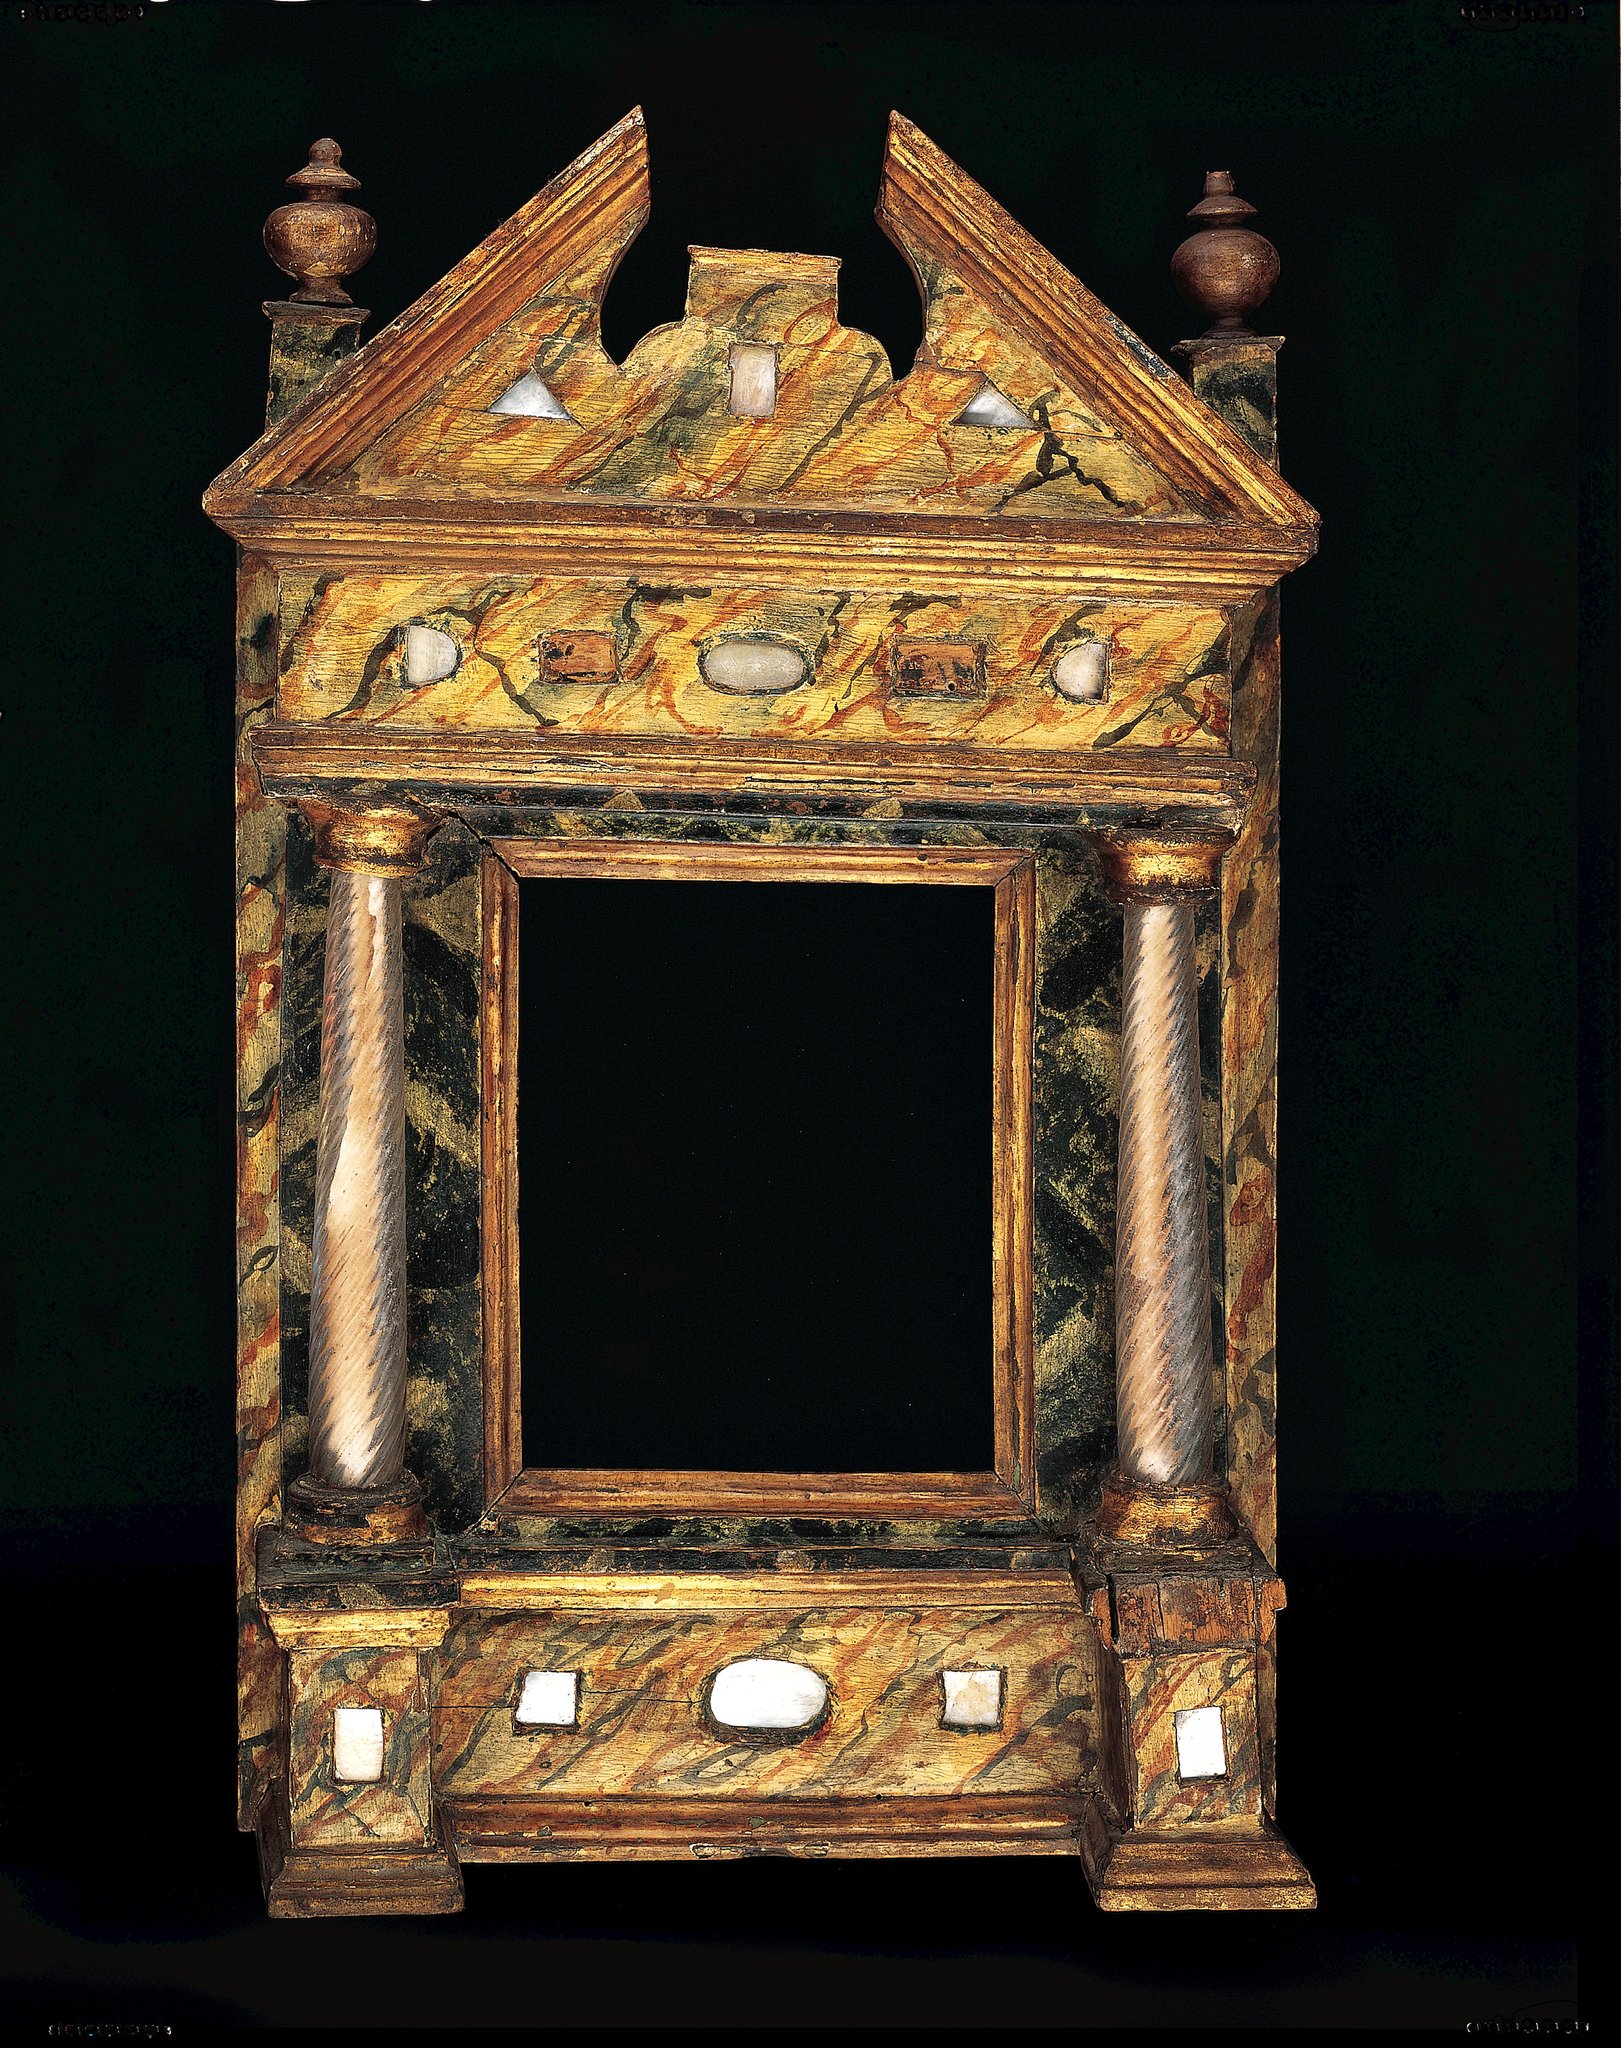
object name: frame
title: Tabernacle frame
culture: italian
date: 1601-1633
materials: marble, mother of pearl, wood